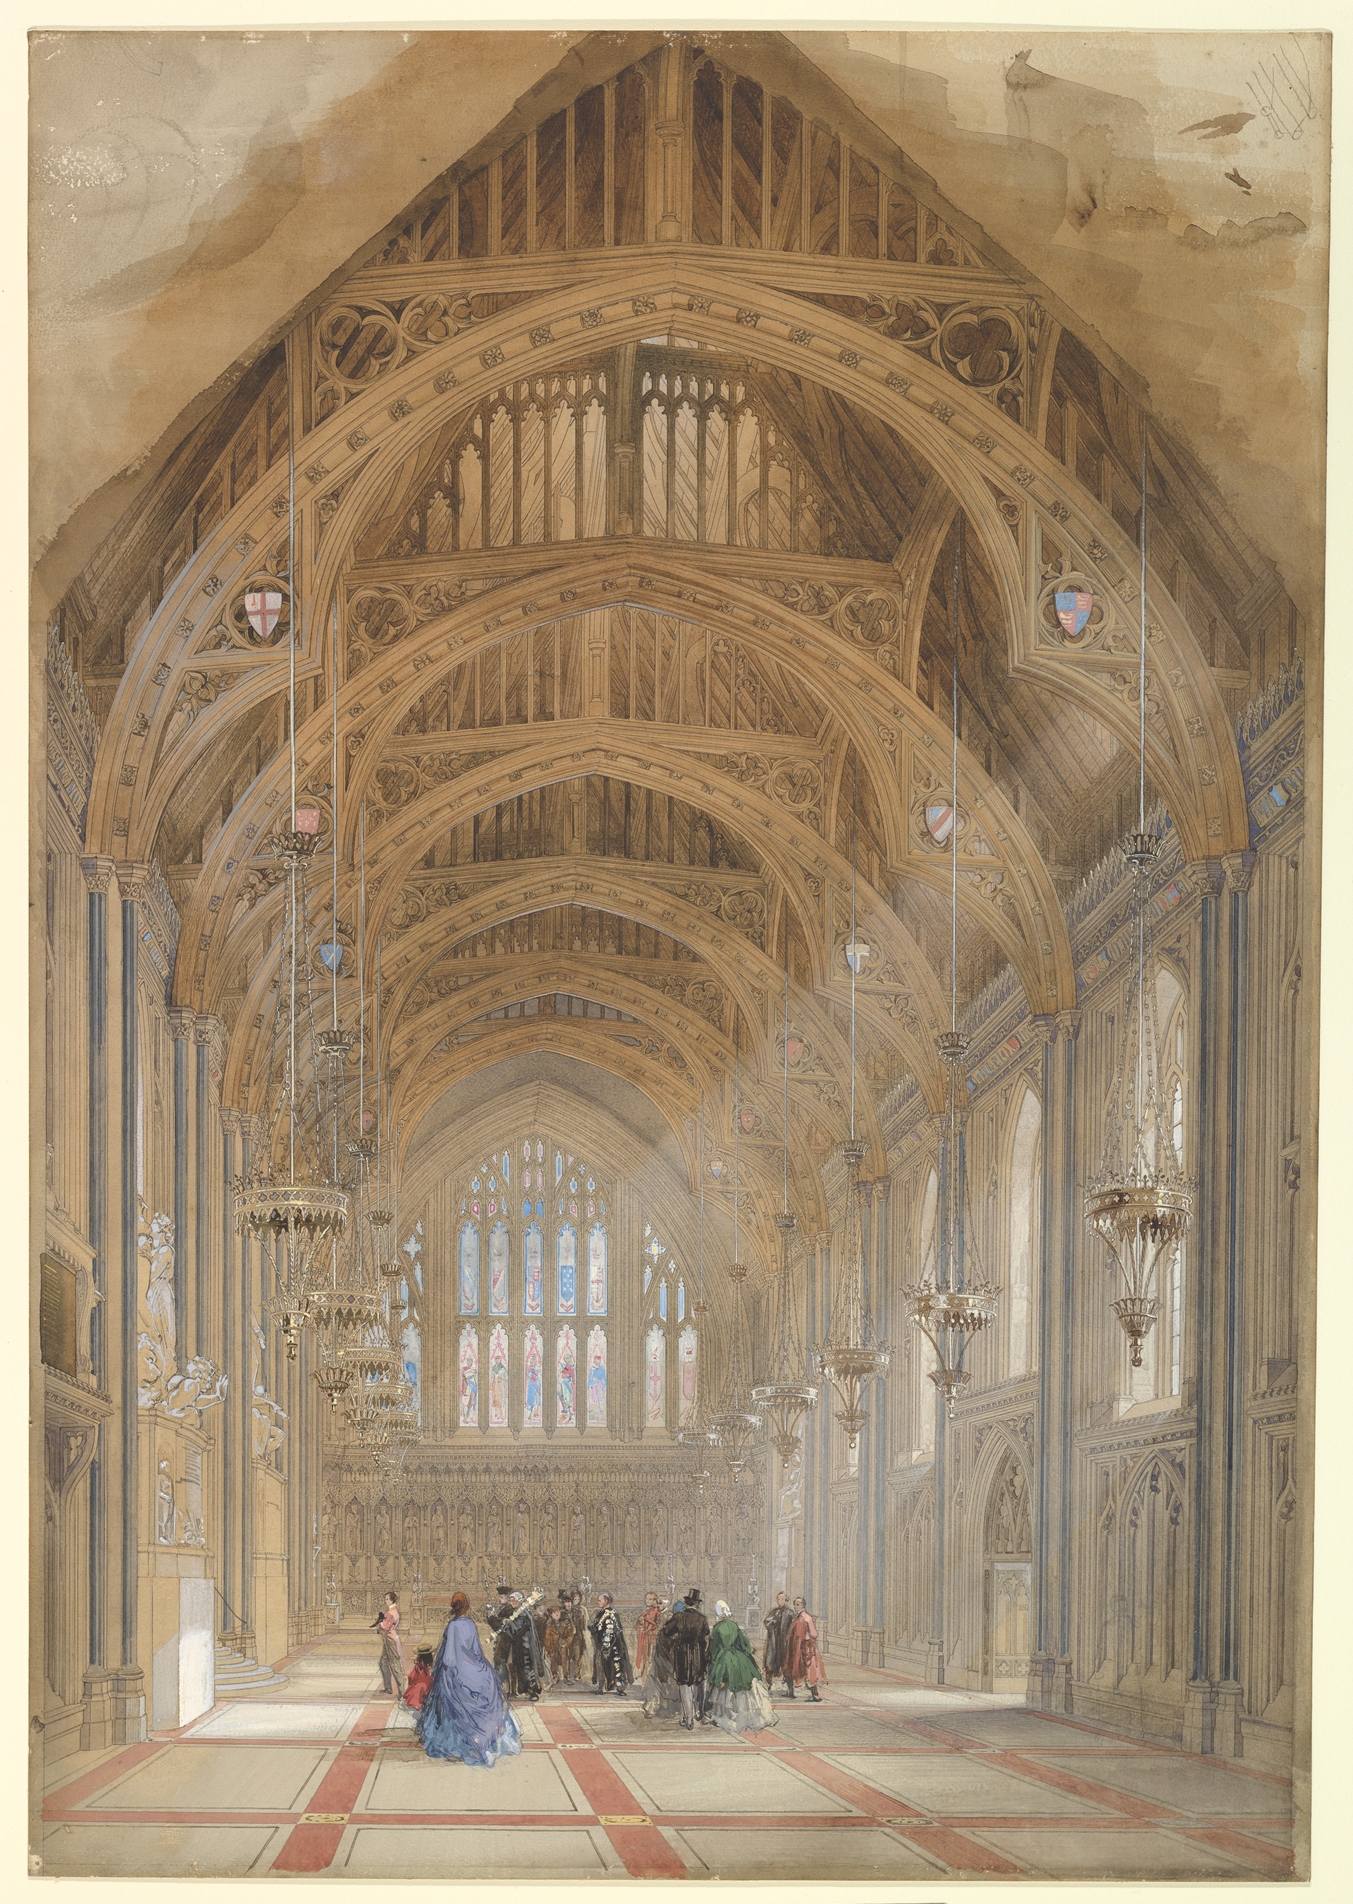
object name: drawing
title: Guildhall, London: The Great Hall, Facing East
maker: sir horace jones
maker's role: artist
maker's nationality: british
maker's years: 1819-1887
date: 1864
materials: graphite, ink, watercolor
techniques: pen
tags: buildings,interiors